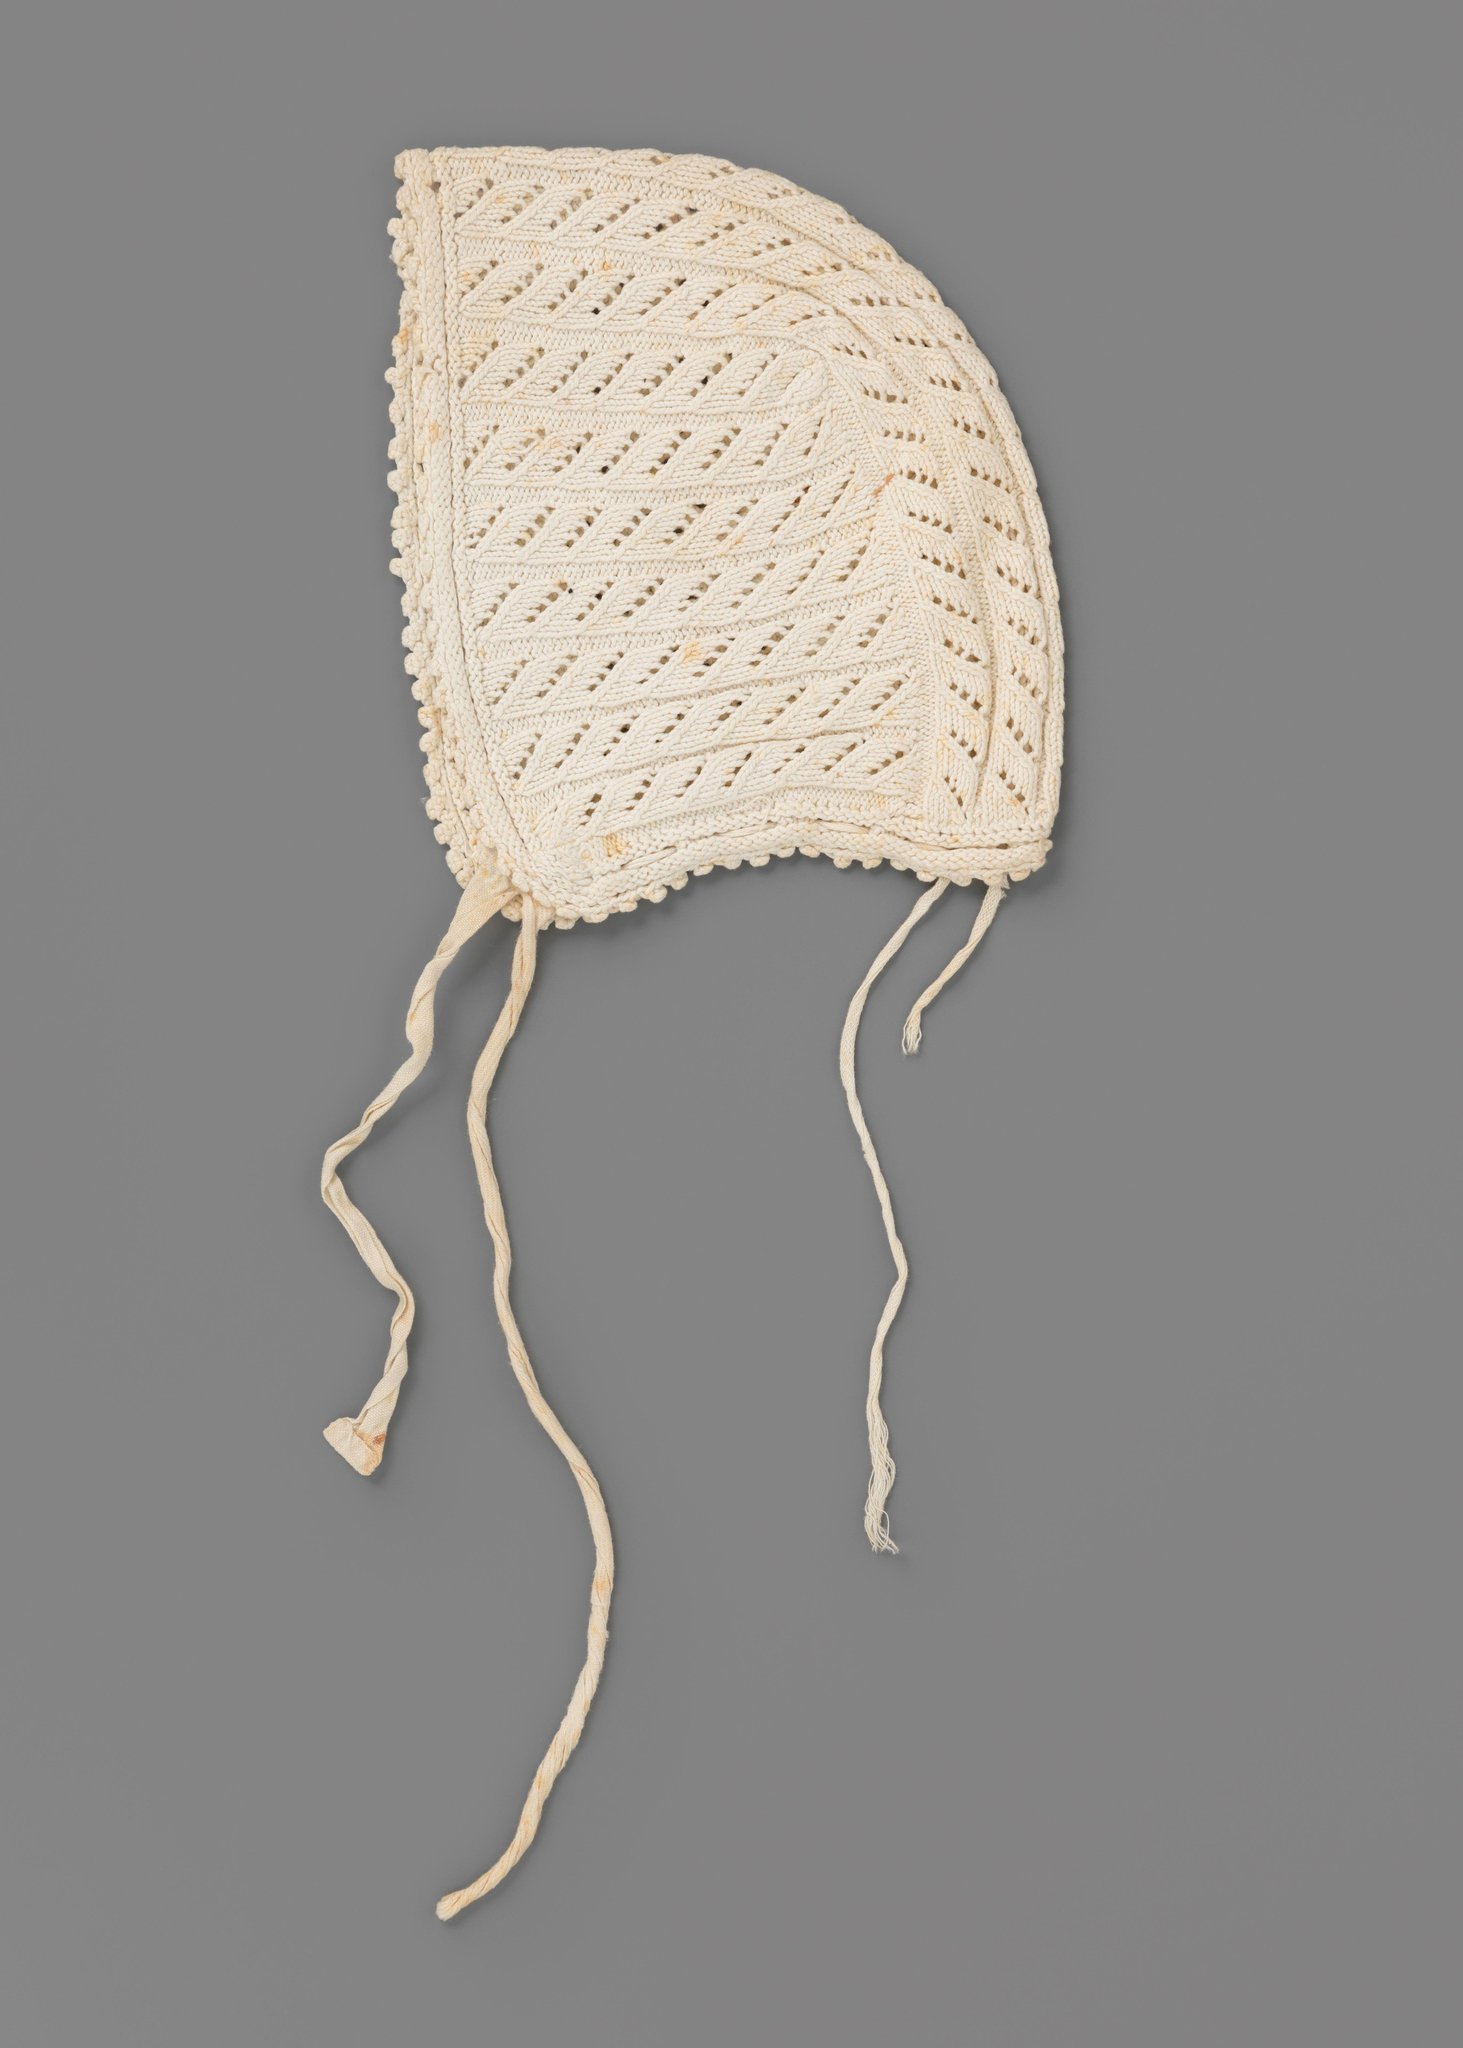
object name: streekdracht, streekkleding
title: Muts voor daagse- of onderdracht van gebreide katoen; kabelpatroon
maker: Anonymous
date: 1800-1900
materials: cotton, linen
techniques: knitting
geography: friesland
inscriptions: mark: ‘51’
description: Muts voor daagse- of onderdracht van gebreide katoen. De muts heeft een kabelpatroon. Met twee kinnenbanden van linnen. Aan de achterzijde kan de muts worden aangetrokken met linnen linten.